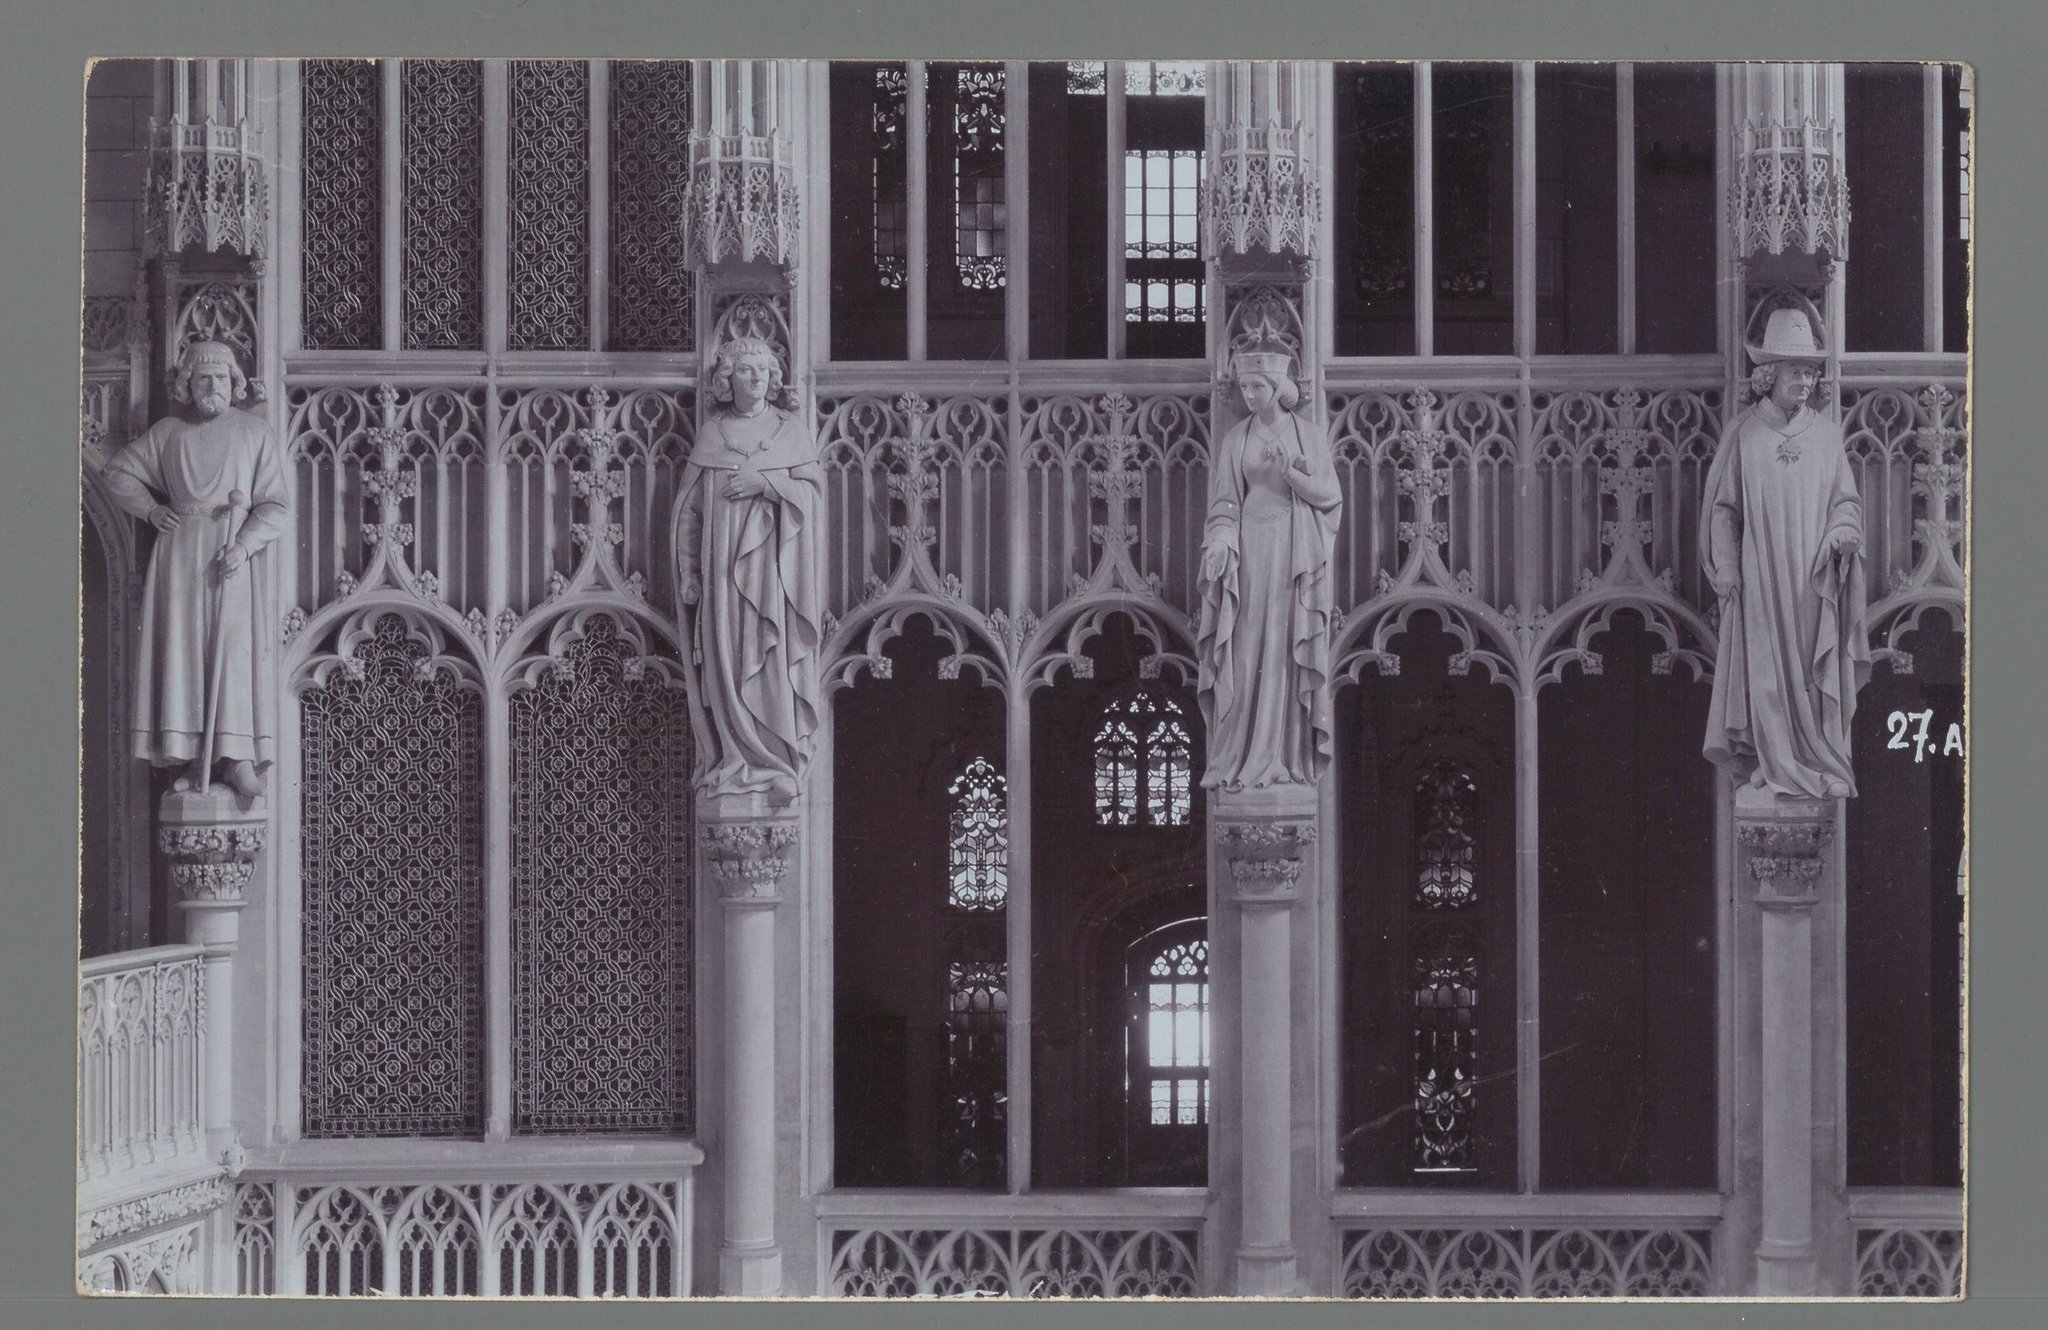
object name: photograph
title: Gezicht op de centrale hal van Kasteel De Haar met zuilen en beelden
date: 1900-1930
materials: paper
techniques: collodion silver print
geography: haarzuilens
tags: column, pillar ~ architecture, castle, monument, statue, vestibule, hall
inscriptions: monogram: ‘M.R.A. U.’